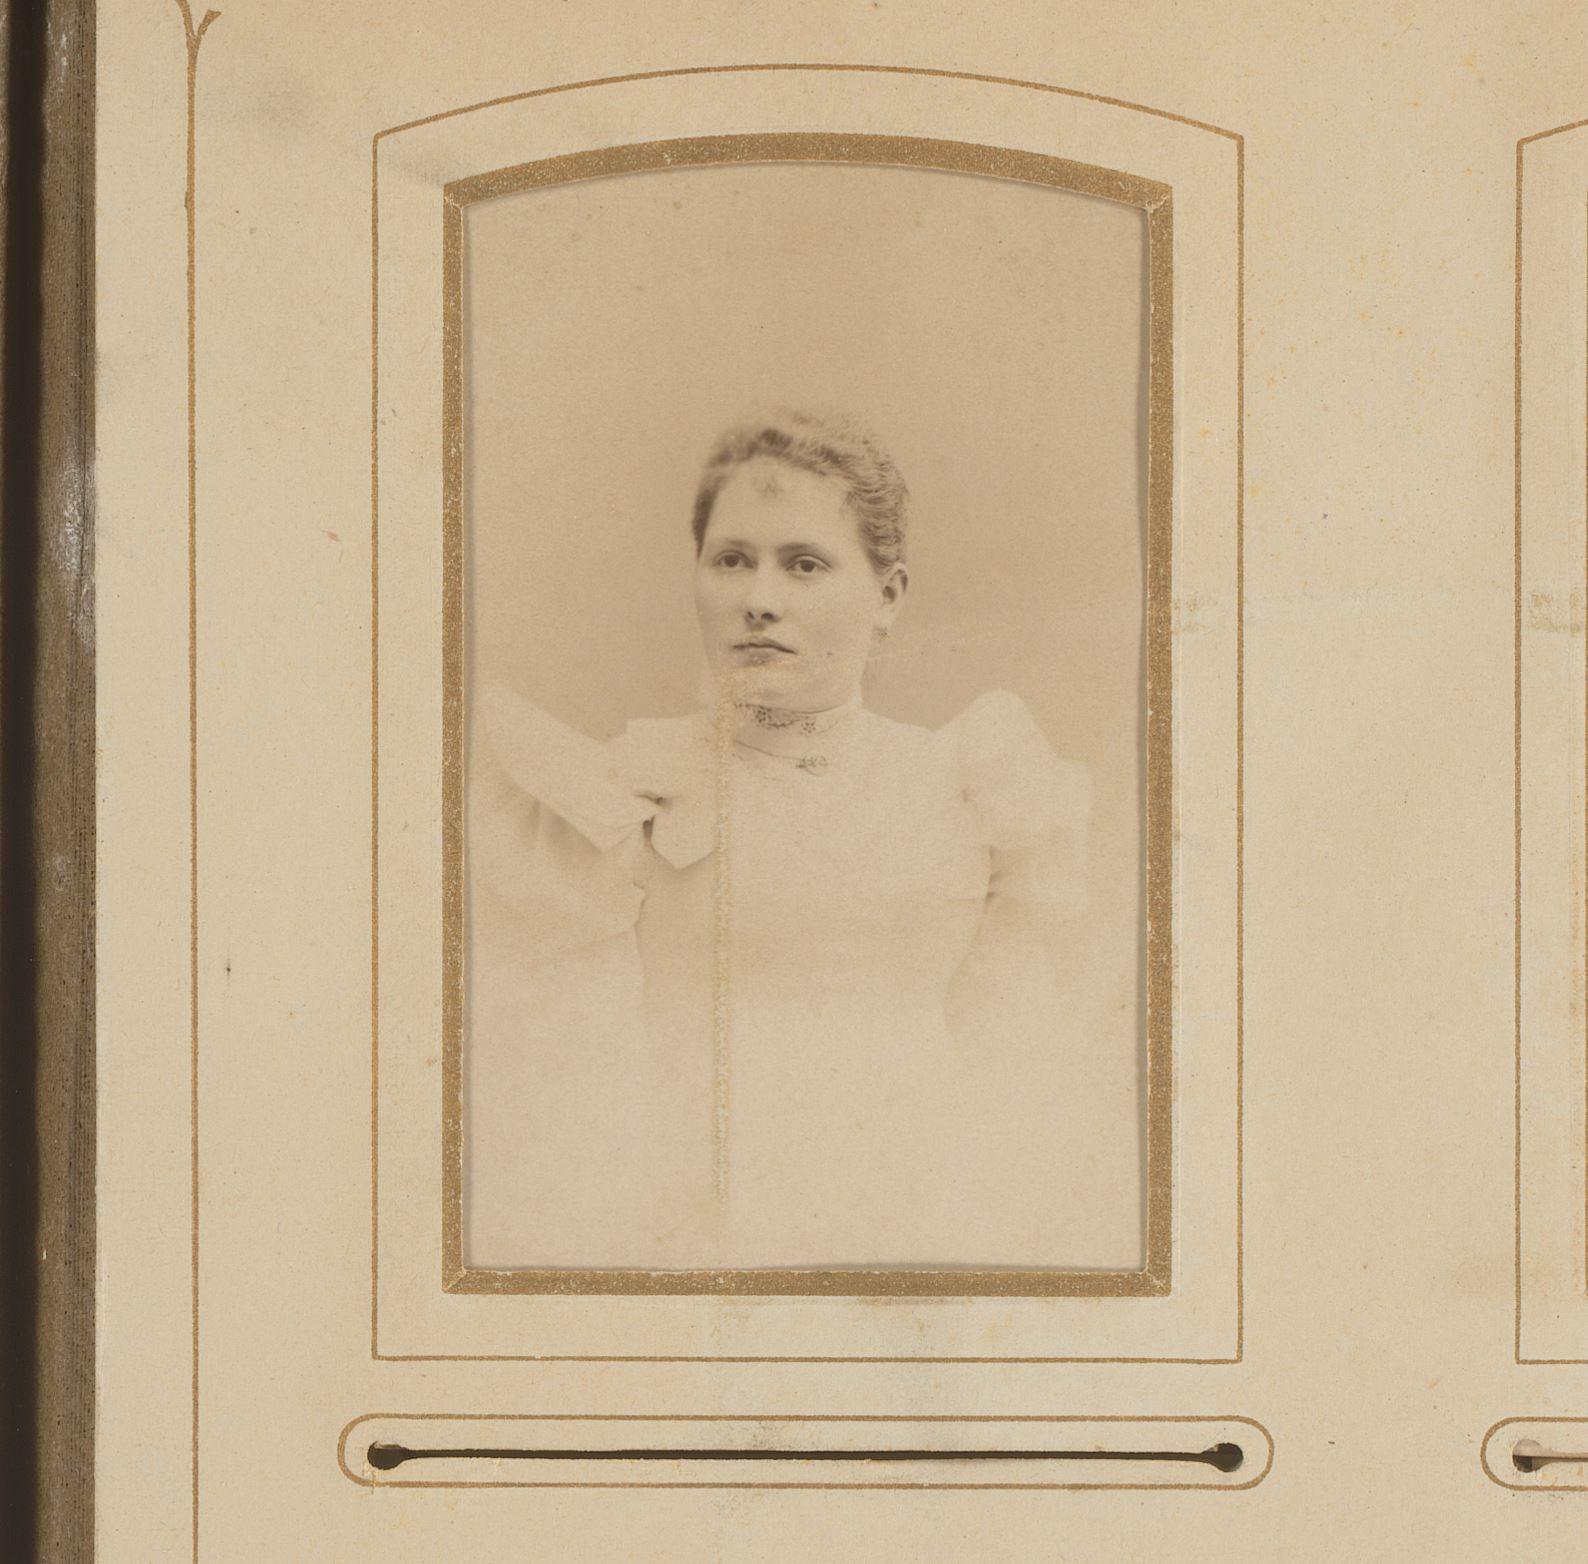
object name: album leaf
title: Portret van een vrouw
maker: hans rupprecht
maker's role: fotograaf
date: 1895-1910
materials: cardboard, photographic support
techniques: albumen print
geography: bremen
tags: historical persons - bb - woman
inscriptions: inscription: ‘Görlitz 1895/ Hans Rüpprecht/ Photogr. Atelier/ Bremen/ Osterhorsteinweg No49/ vis-à-vis der Mozartstr.’